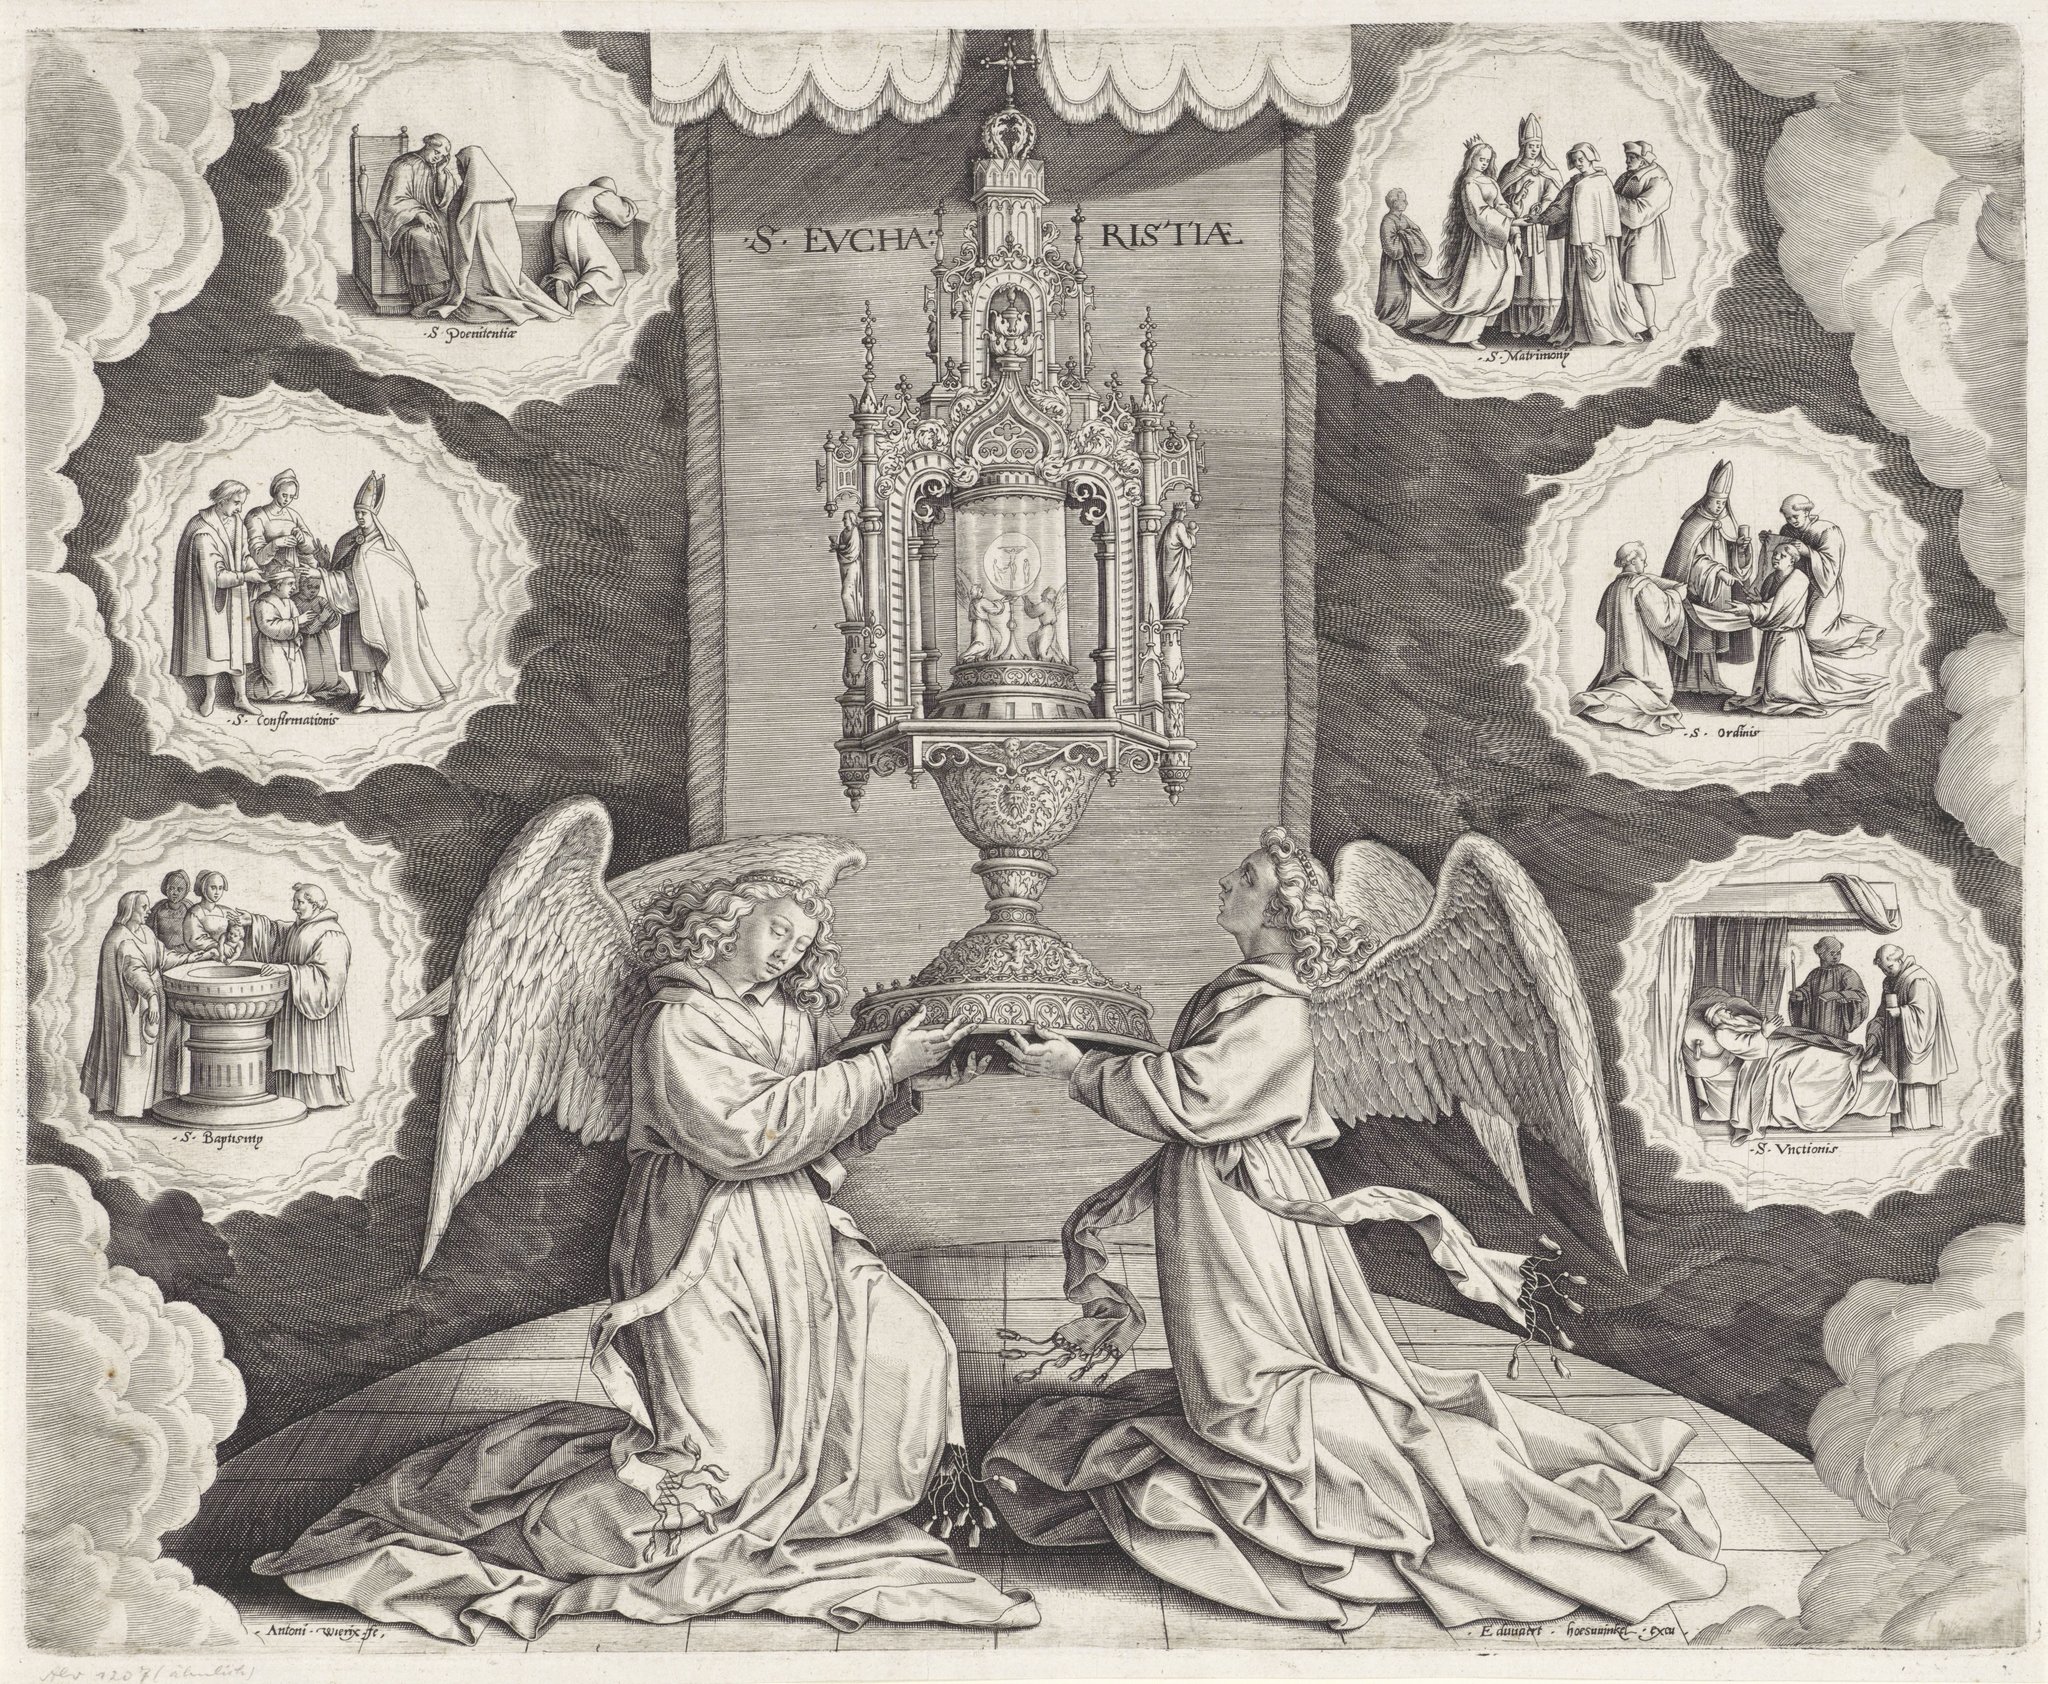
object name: print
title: S. Evcharistiæ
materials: paper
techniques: engraving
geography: antwerp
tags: ostensorium, monstrance (+ angel(s)), the seven sacraments of the roman catholic church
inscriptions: collector's mark: Lugt 2228, collector's mark: Lugt 2542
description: De zeven sacramenten verbeeld, met in het midden de Heilige Communie, gesymboliseerd door twee engelen die een monstrans ophouden. De centrale voorstelling is omringd door medaillons waarin de andere sacramenten zijn voorgesteld. Links, van boven naar beneden: de biecht, het vormsel en de doop. Rechts, van boven naar beneden: het huwelijk, de priesterwijding en het oliesel.